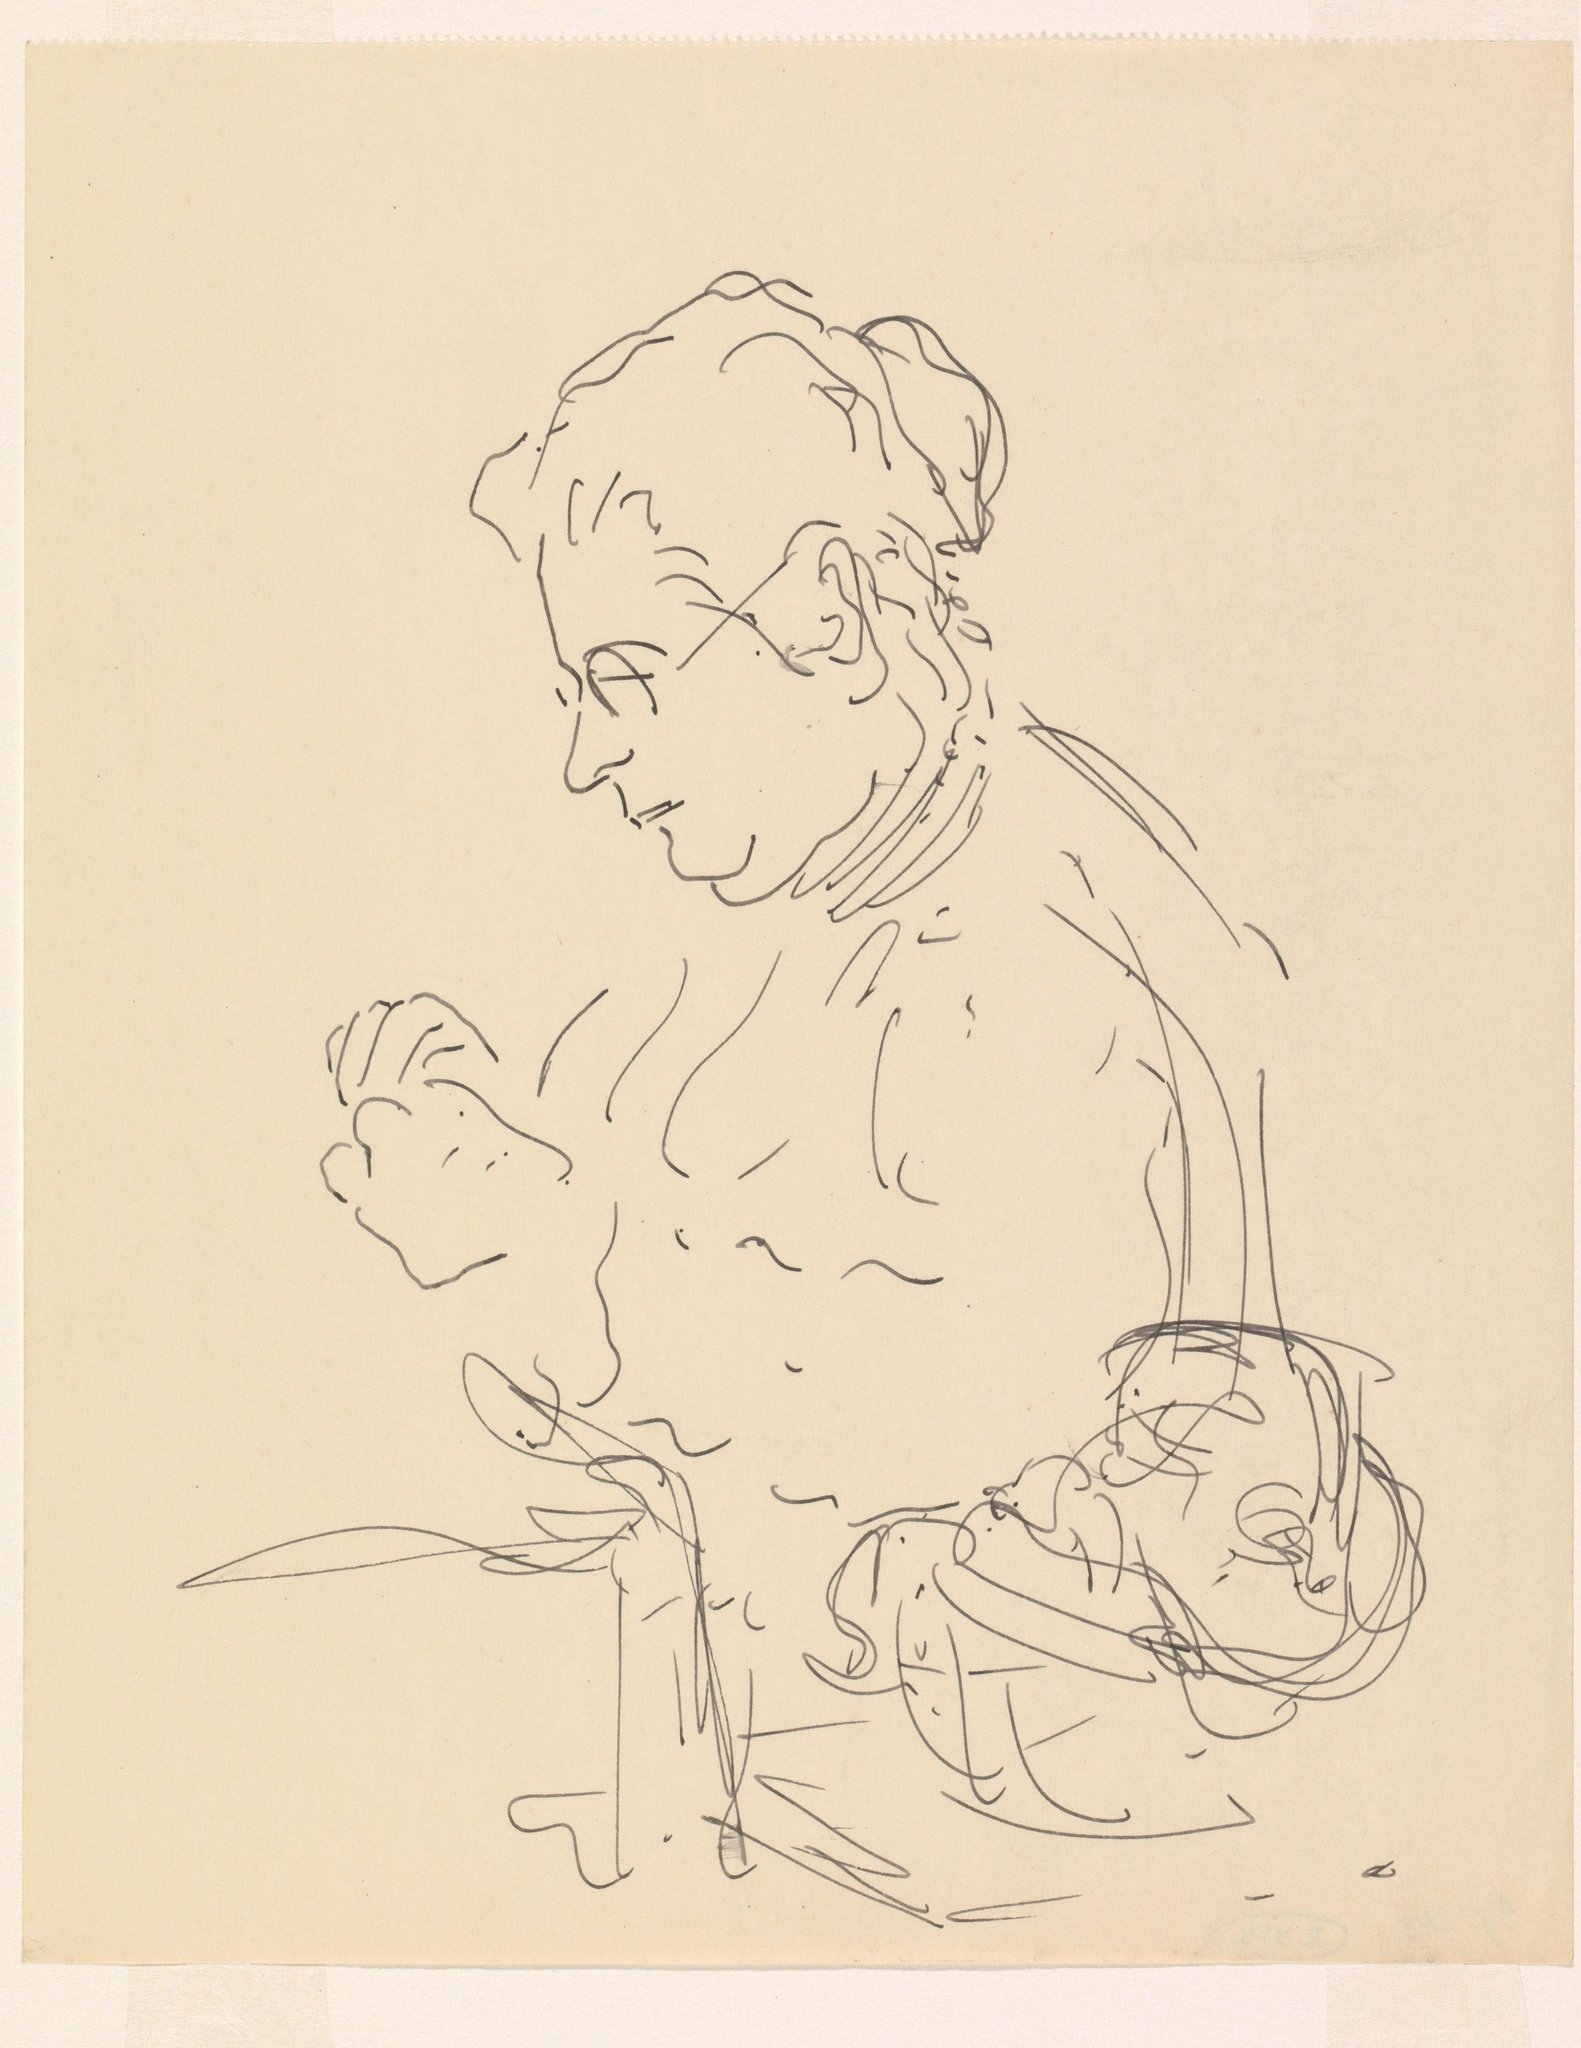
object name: drawing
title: Studie van de echtgenote van Carel Adolph Lion Cachet, handwerkend, van opzij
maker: carel adolph lion cachet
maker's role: draughtsman, print maker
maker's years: 1864-1945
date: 1874-1945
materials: ink, paper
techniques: pen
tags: historical persons - bb - woman, (other forms of) needlework, e.g.: crocheting, knitting, embroidering